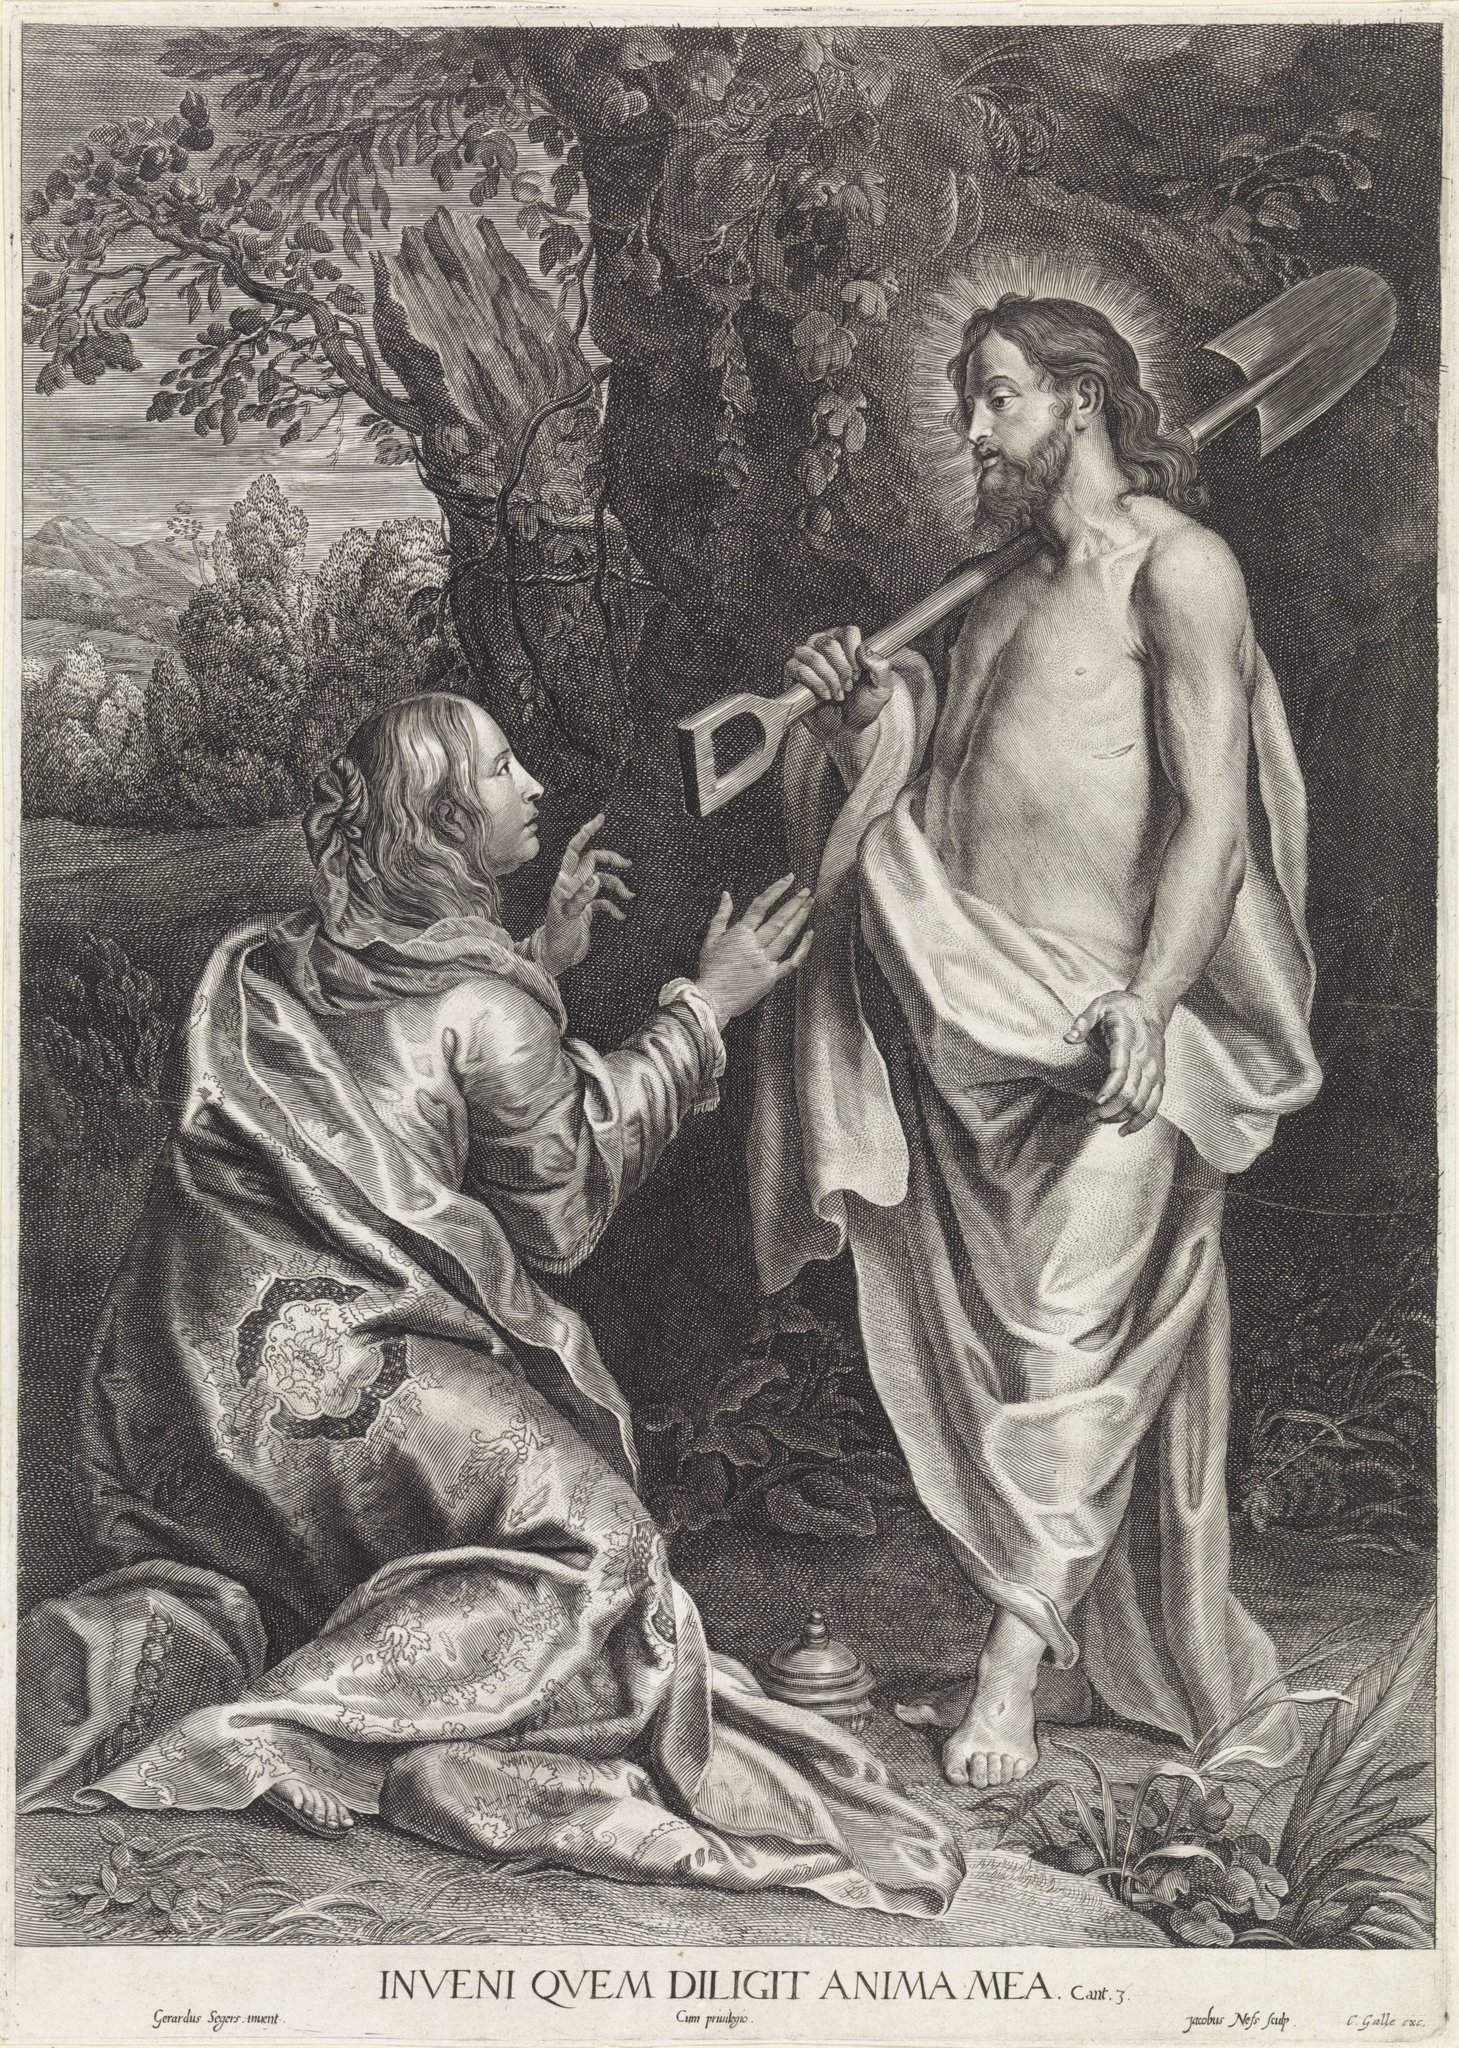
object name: print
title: Christus verschijnt aan Maria Magdalena (Noli me tangere)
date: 1620-1680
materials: paper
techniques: engraving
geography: antwerp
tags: mary magdalene kneeling before christ, who is usually represented as a gardener with a hoe and/or a spade; 'noli me tangere'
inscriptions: collector's mark: Lugt 240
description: Maria Magdalena knielt voor Christus in een landschap. Hij staat tegenover haar met een spade op zijn schouder, de wond in zijn zij zichtbaar. Naast Maria Magdalena staat haar zalfpot. Onderaan in de marge een Bijbelvers in het Latijn uit Hoogl. 3.